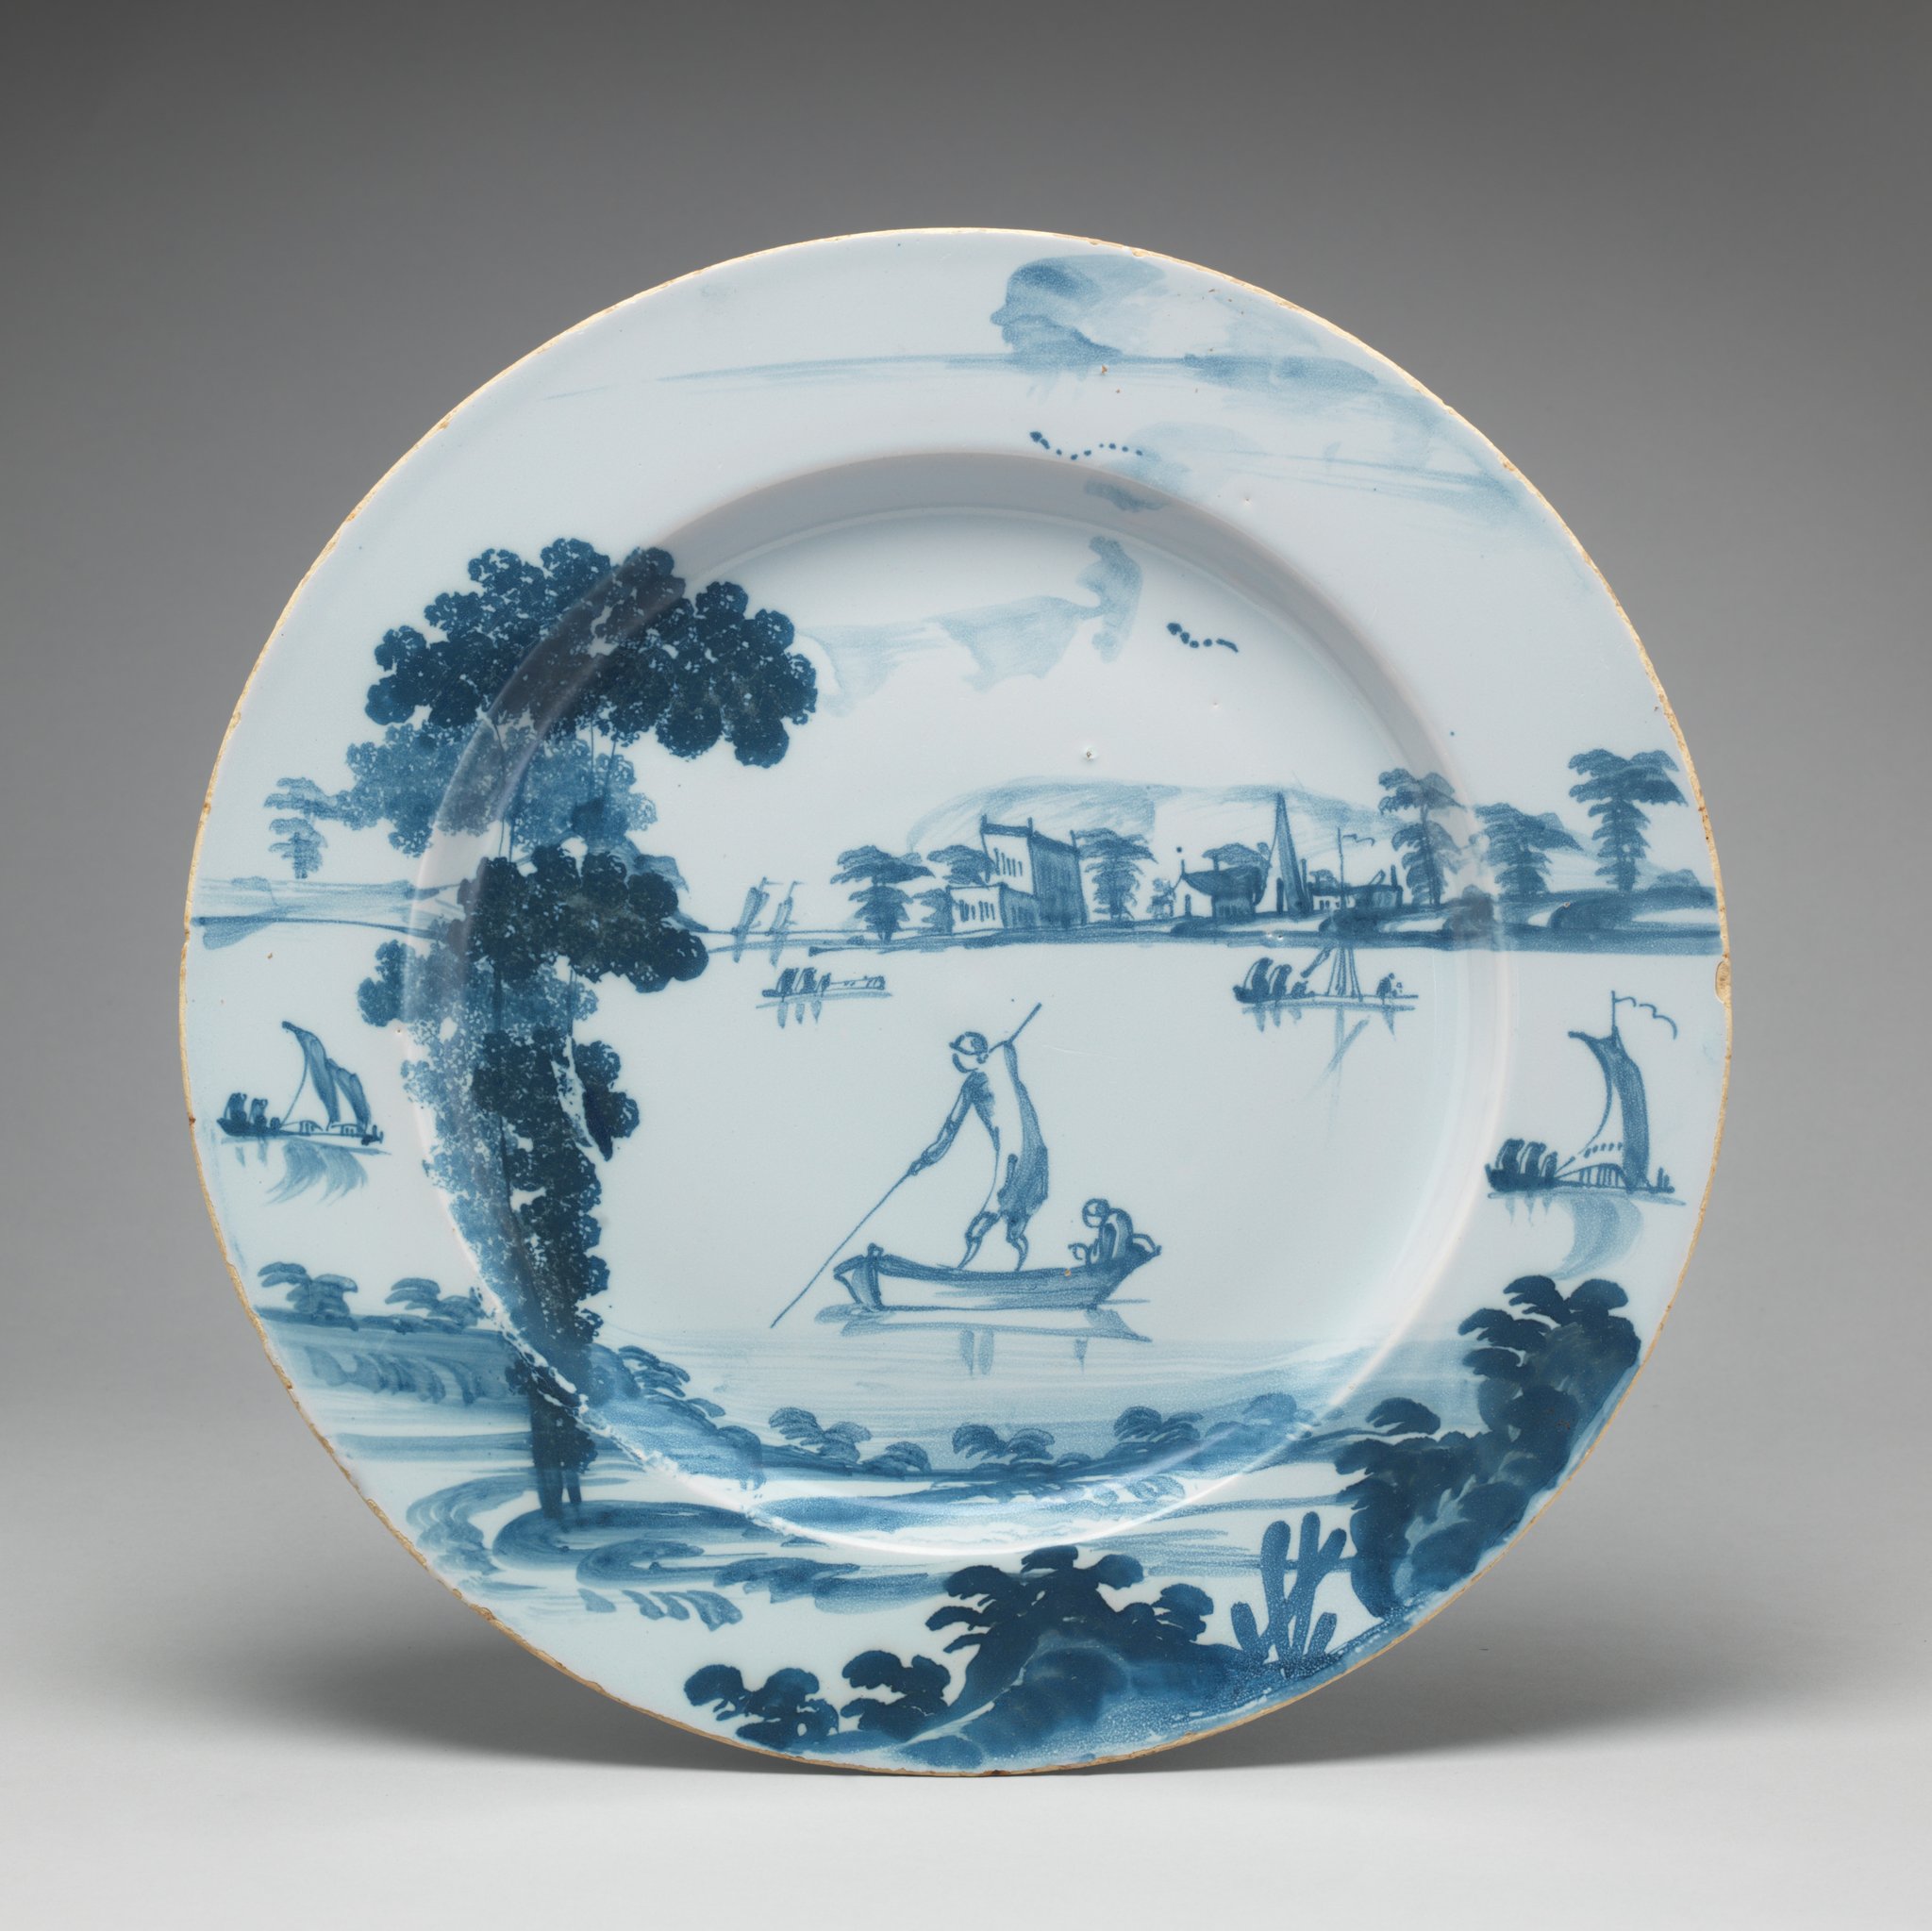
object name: dish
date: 1760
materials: earthenware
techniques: glazing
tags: boats